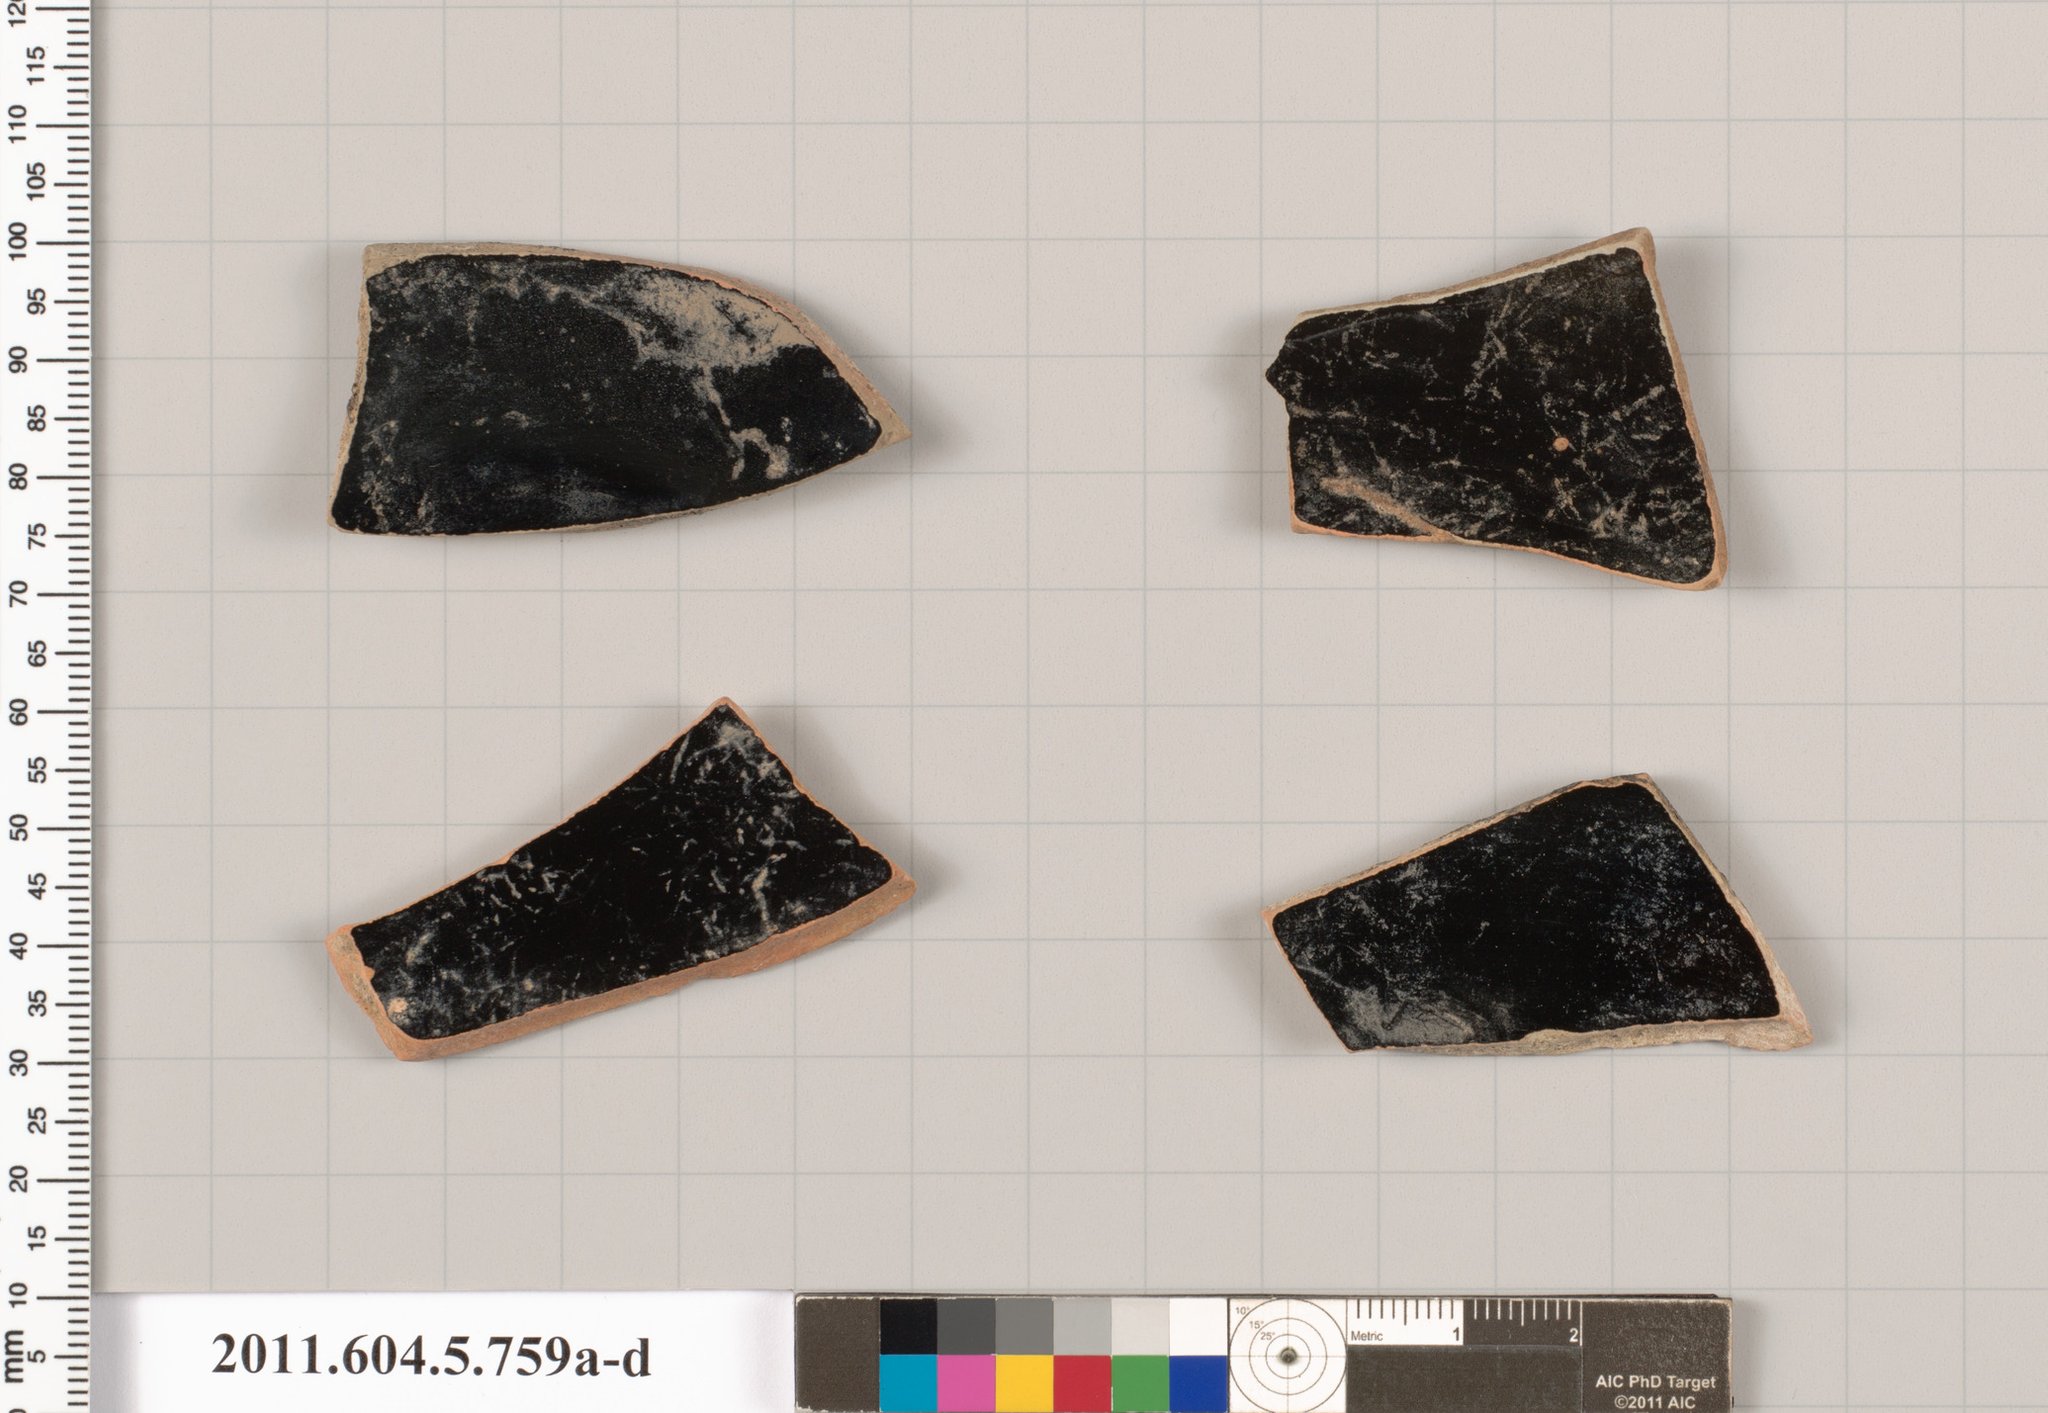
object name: kylix fragment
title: Terracotta fragments of kylikes (drinking cups)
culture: greek, attic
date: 600-401 BCE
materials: terracotta